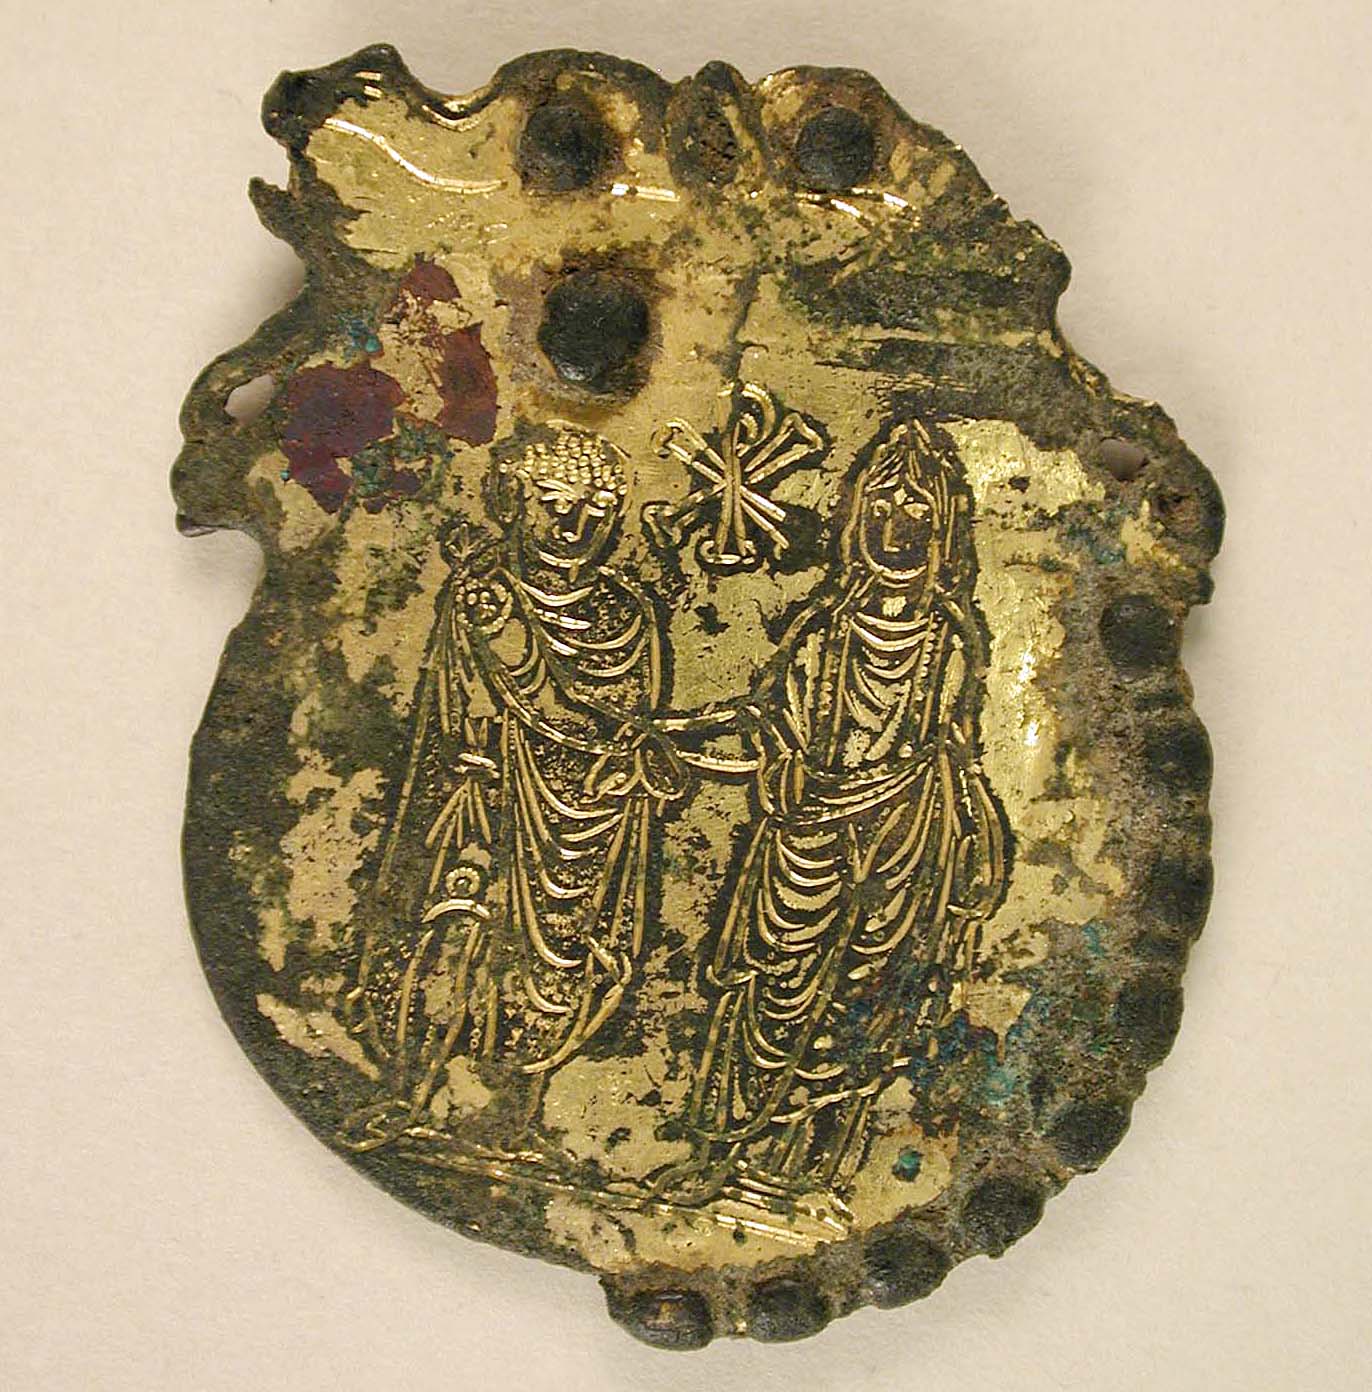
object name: belt end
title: Belt Ornament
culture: byzantine or roman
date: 301-400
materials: copper alloy, gilt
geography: rome (possibly)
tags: couples,men,women,pegasus